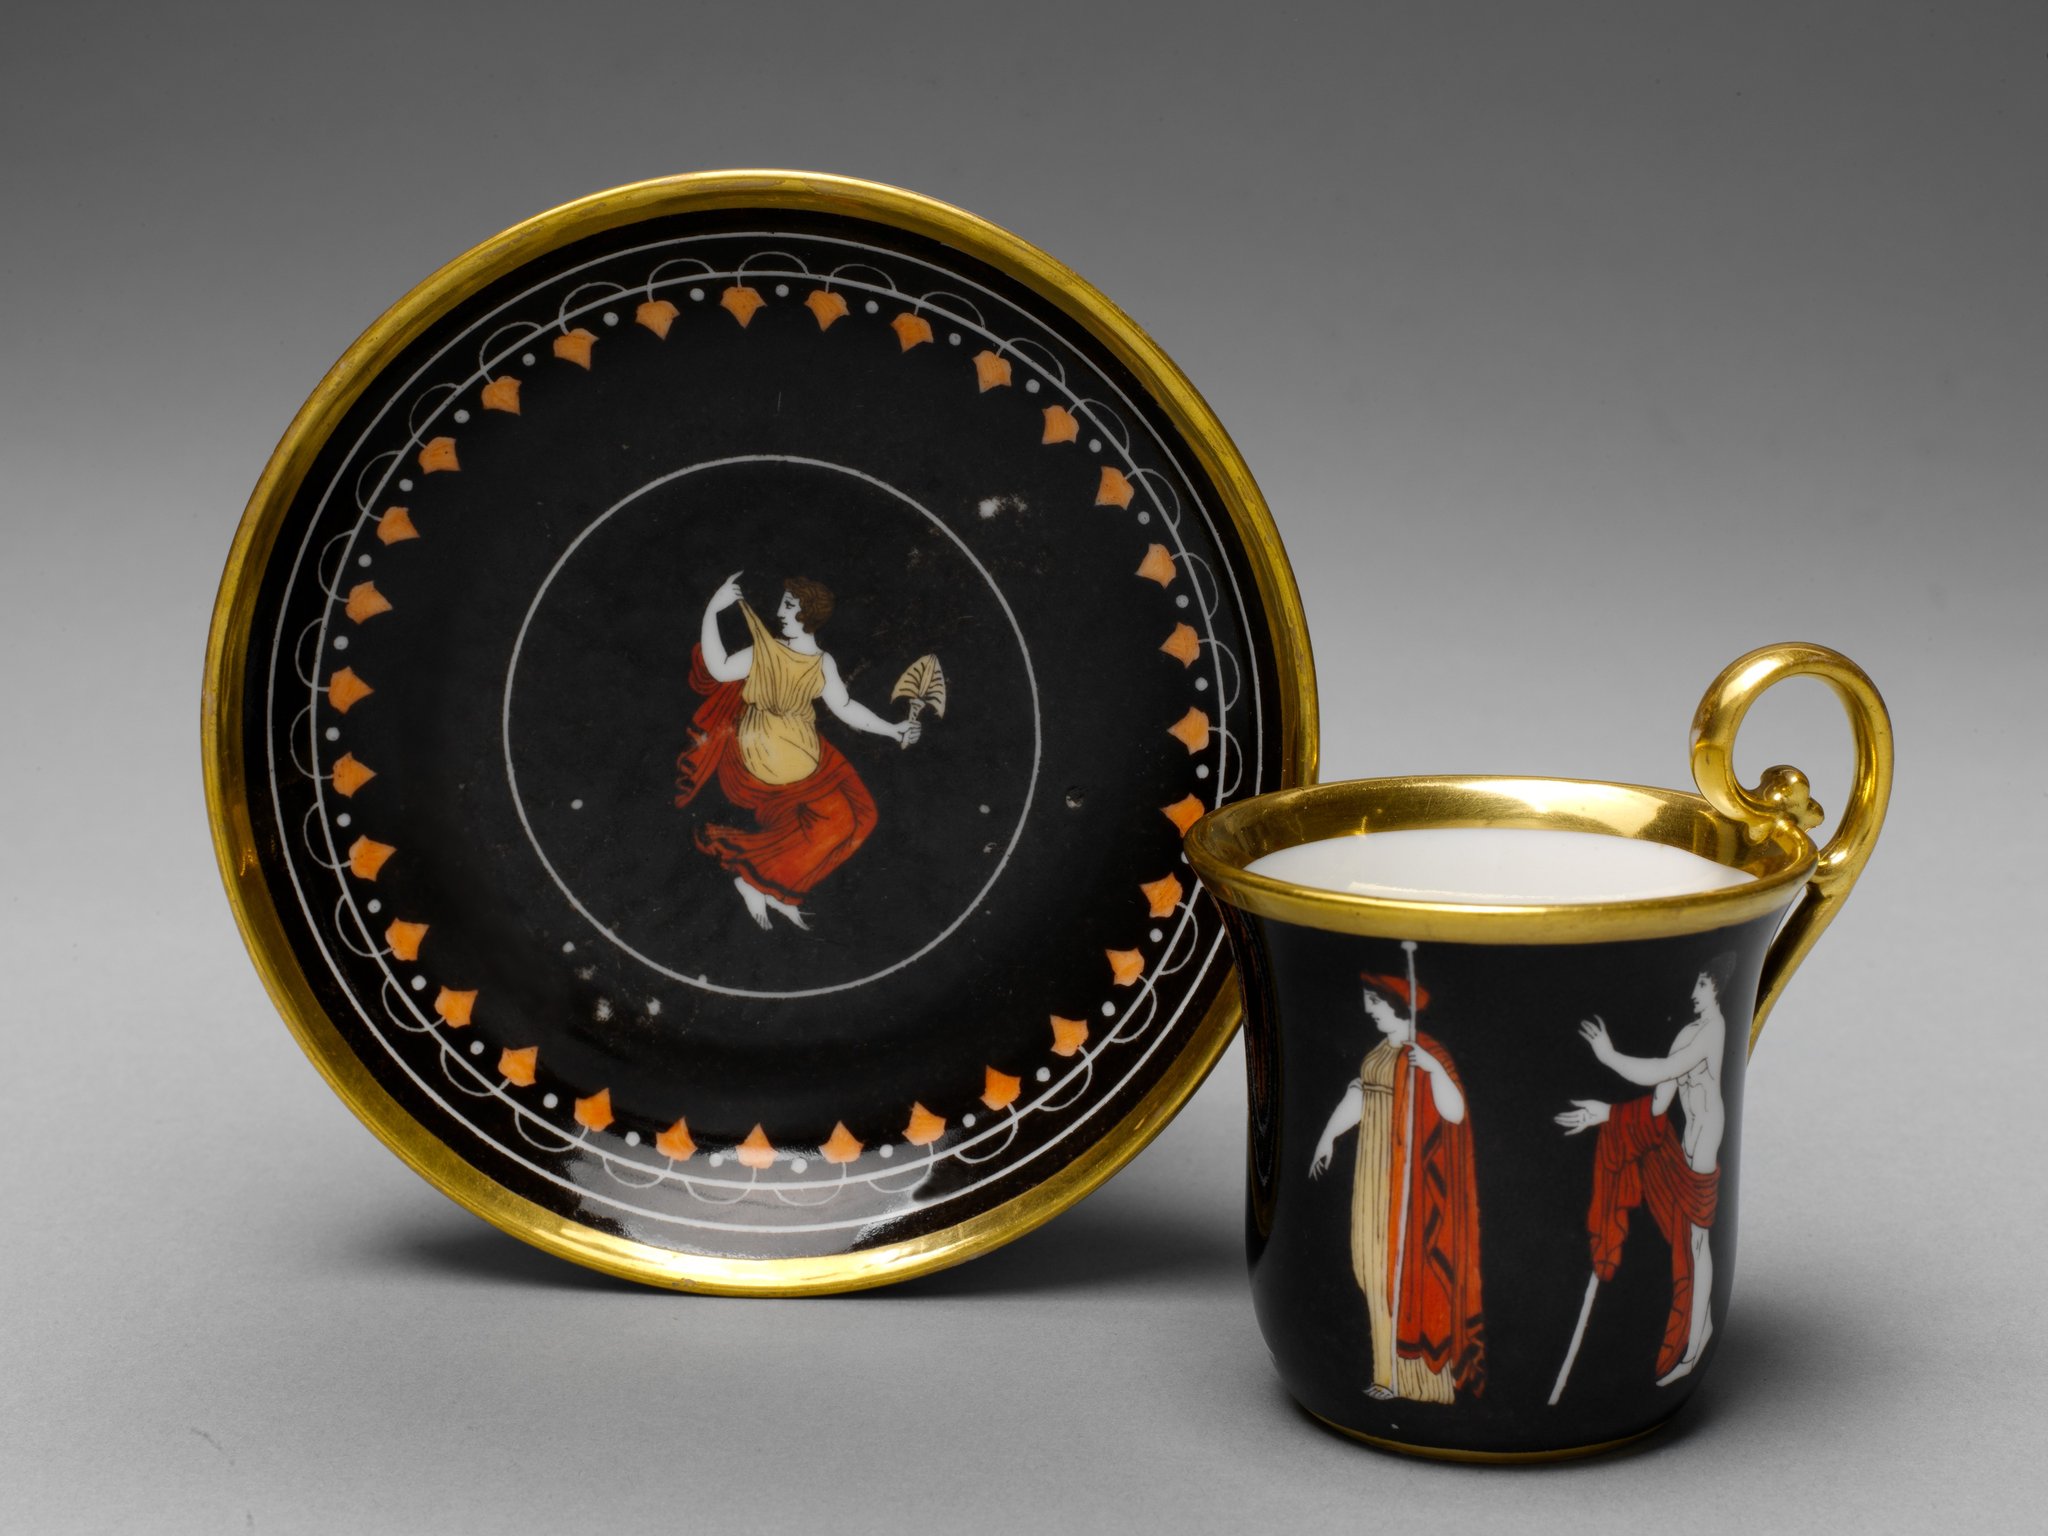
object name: cup and saucer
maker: dagoty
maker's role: maker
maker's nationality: french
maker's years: 1798-1820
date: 1810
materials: hard paste porcelain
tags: men,women